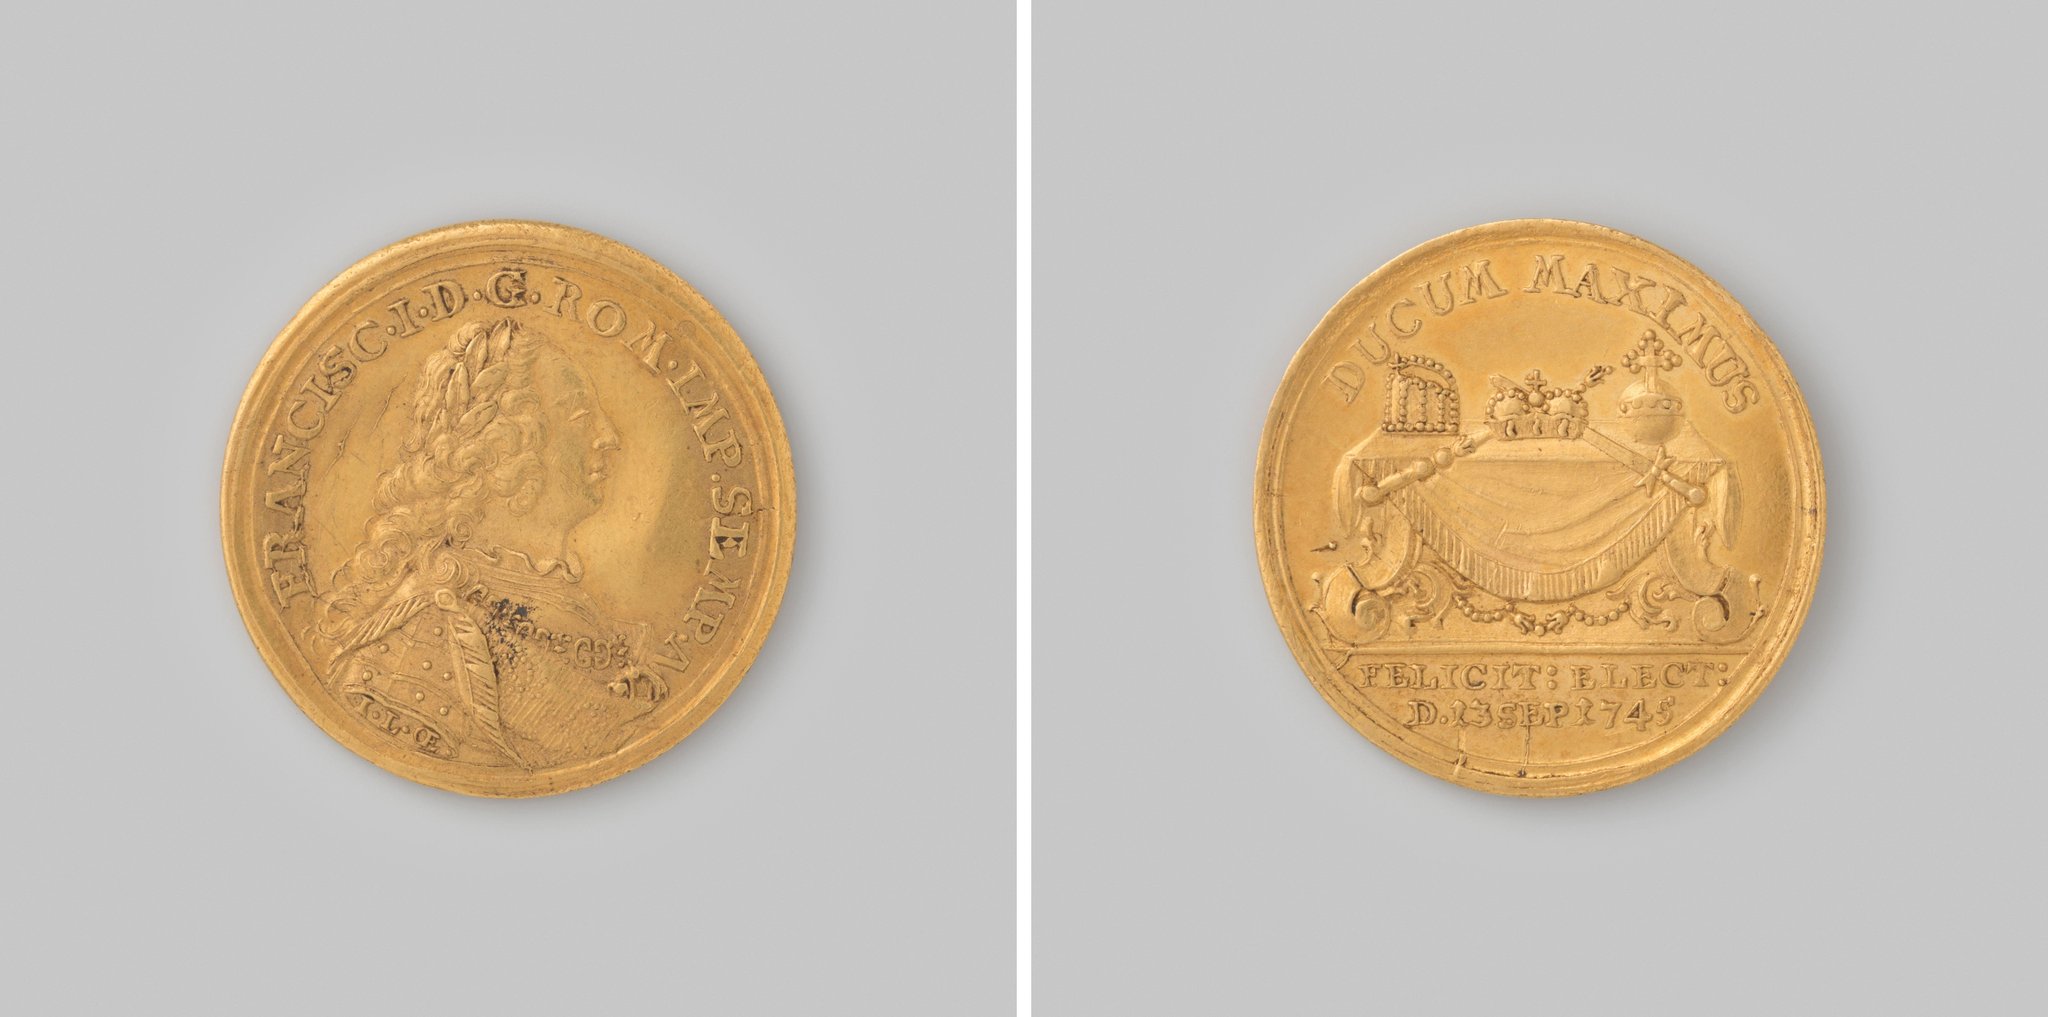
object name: coin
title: Dukaat uit het Duitse keizerrijk van keizer Franz I Stephan, 1745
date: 1745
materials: gold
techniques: striking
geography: minden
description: Gouden munt. Voorzijde: borstbeeld van de keizer naar rechts. Keerzijde: met kleed afgedekte sierlijke tafel, waarop de rijksregalia. In afsnede tekst en datum 13 september 1745. Gladde rand. Munt geslagen ter gelegenheid van zijn verkiezing tot keizer.